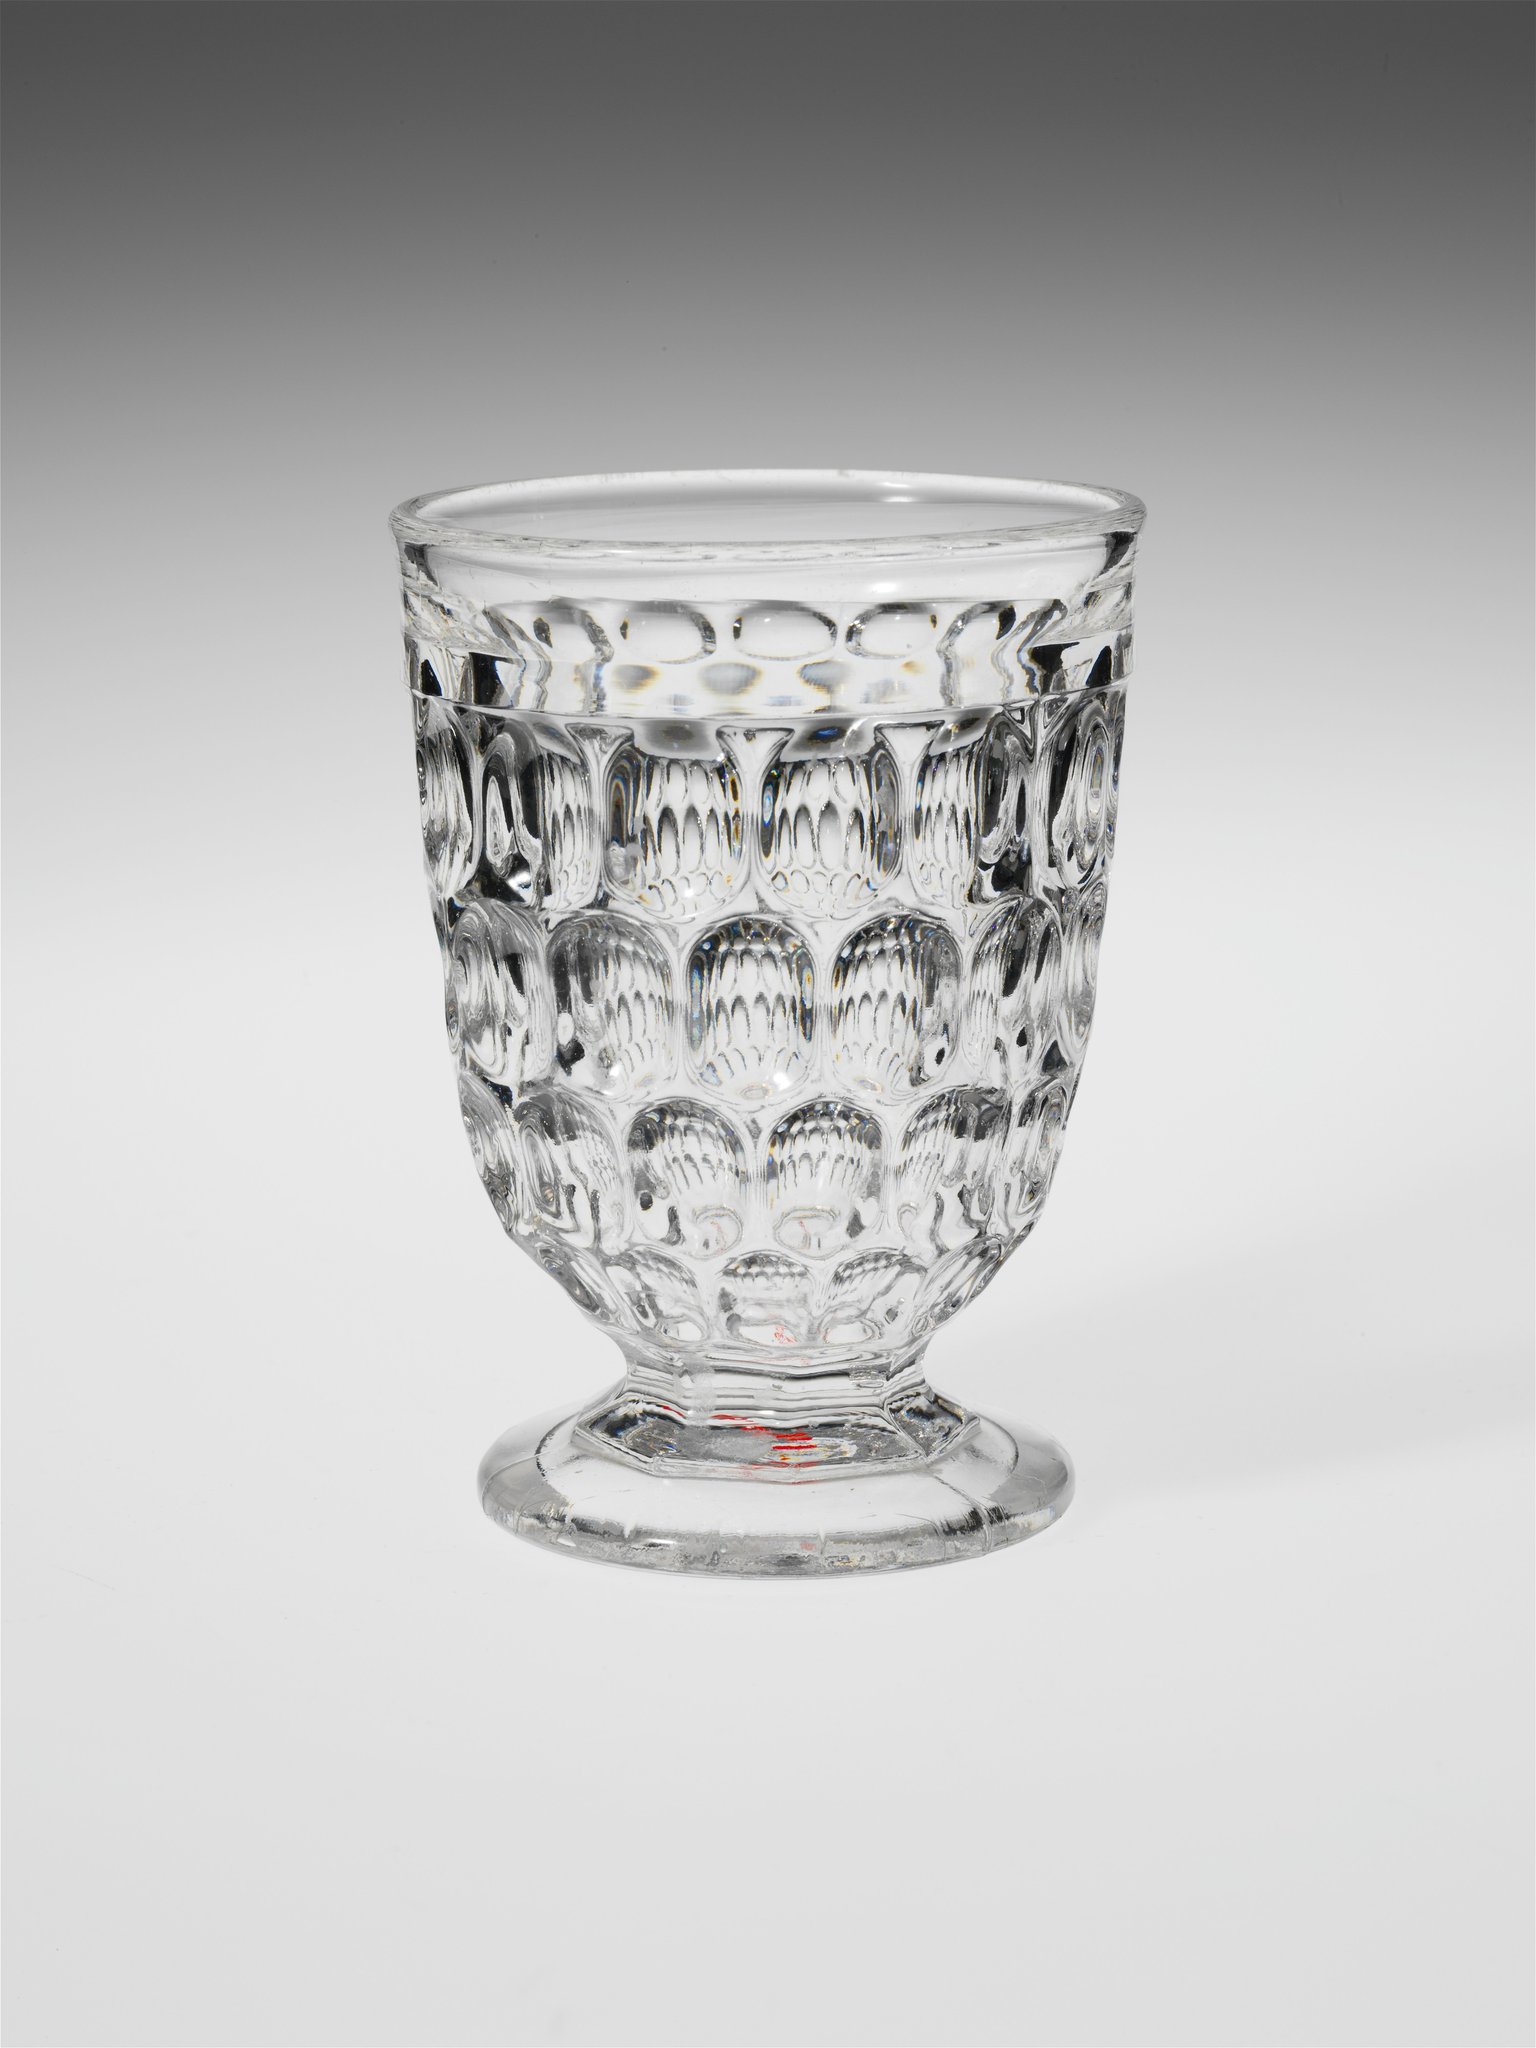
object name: tumbler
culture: american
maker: bakewell, pears and company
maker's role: maker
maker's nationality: american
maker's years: 1836-1882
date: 1850-1870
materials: glass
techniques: pressed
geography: united states